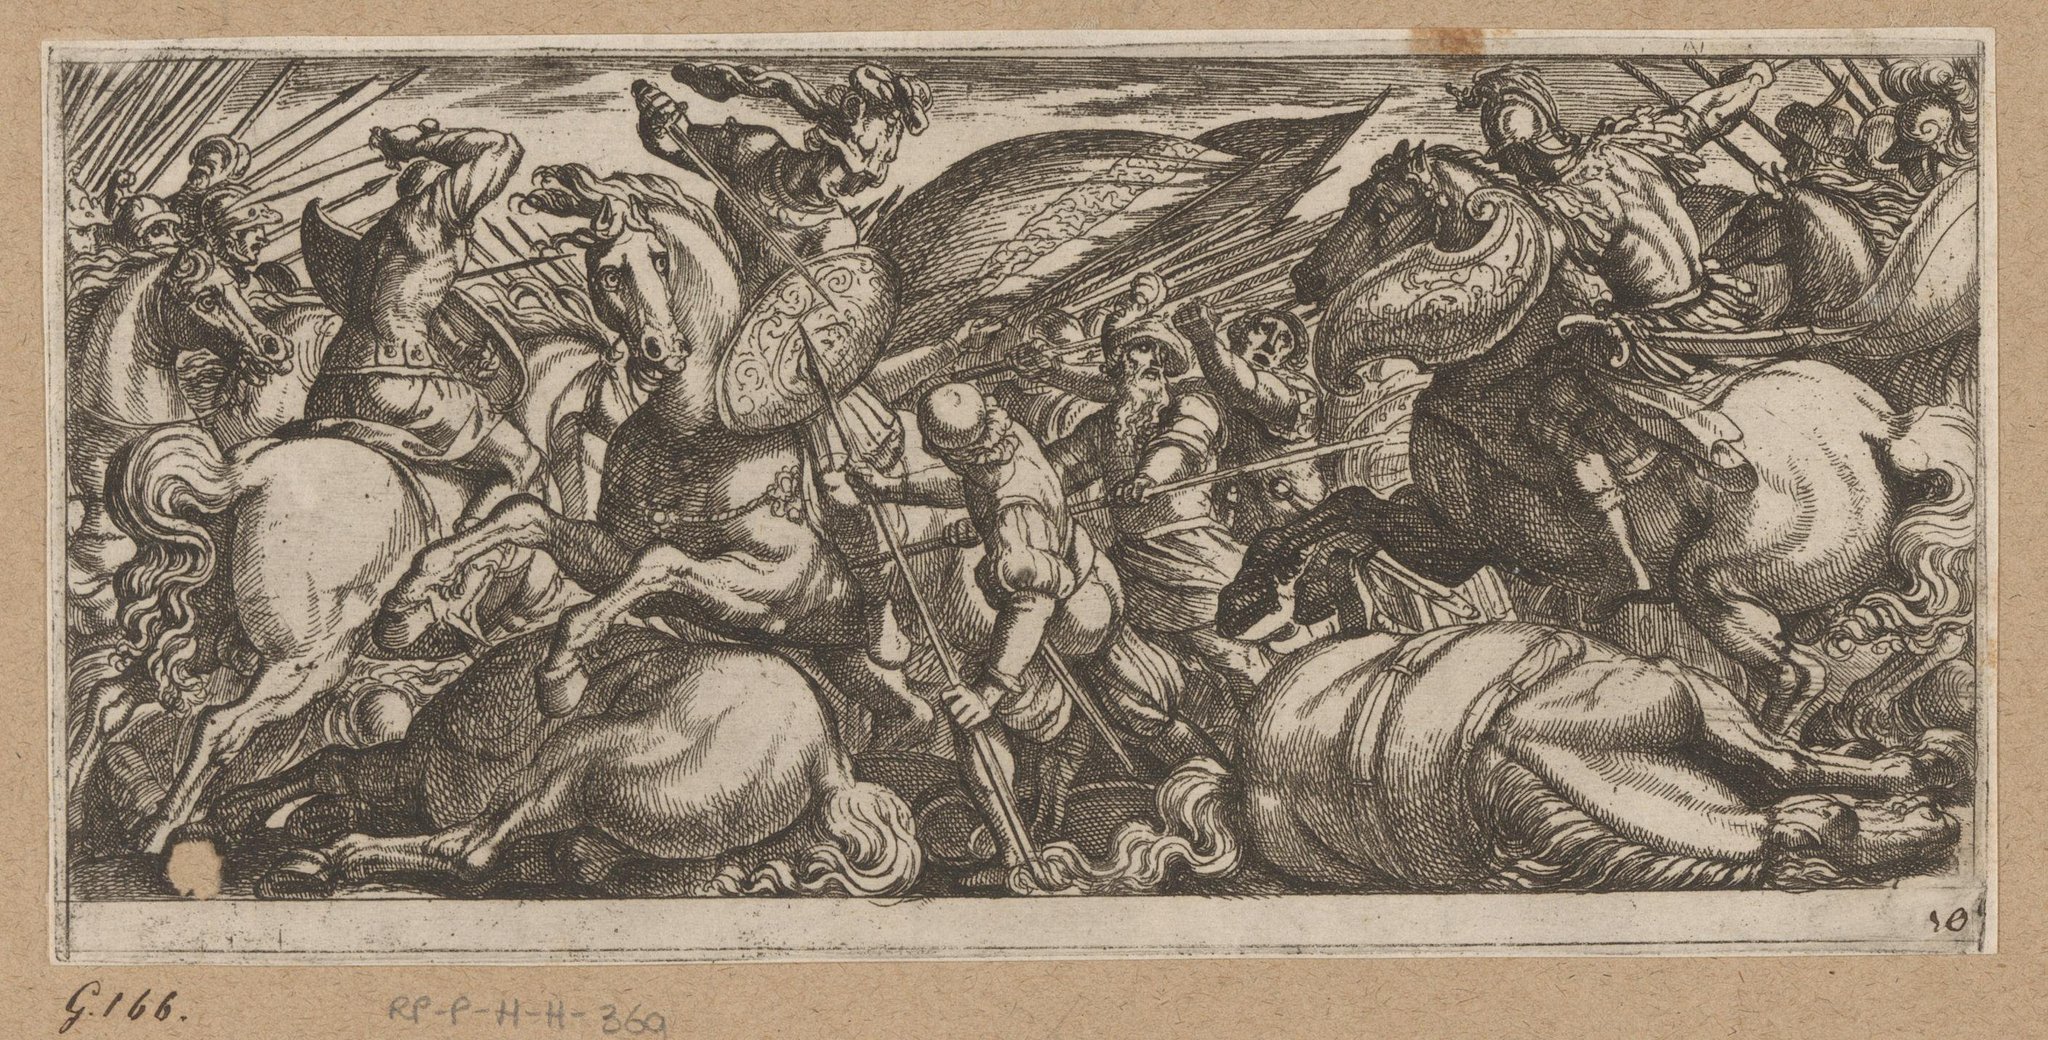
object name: print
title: Gevecht tussen de cavalerie en de infanterie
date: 1565-1630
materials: paper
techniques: etching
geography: rome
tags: battle, warfare; military affairs (+ cavalry, horsemen), the soldier; the soldier's life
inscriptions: number: ‘10’, collector's mark: Lugt 11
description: Deze prent maakt deel uit van een reeks van 10 prenten (+ titelprent) met gevechtsscènes. Antonio Tempesta maakte ook een tweede serie met gevechtsscènes van 9 prenten (+titelprent).